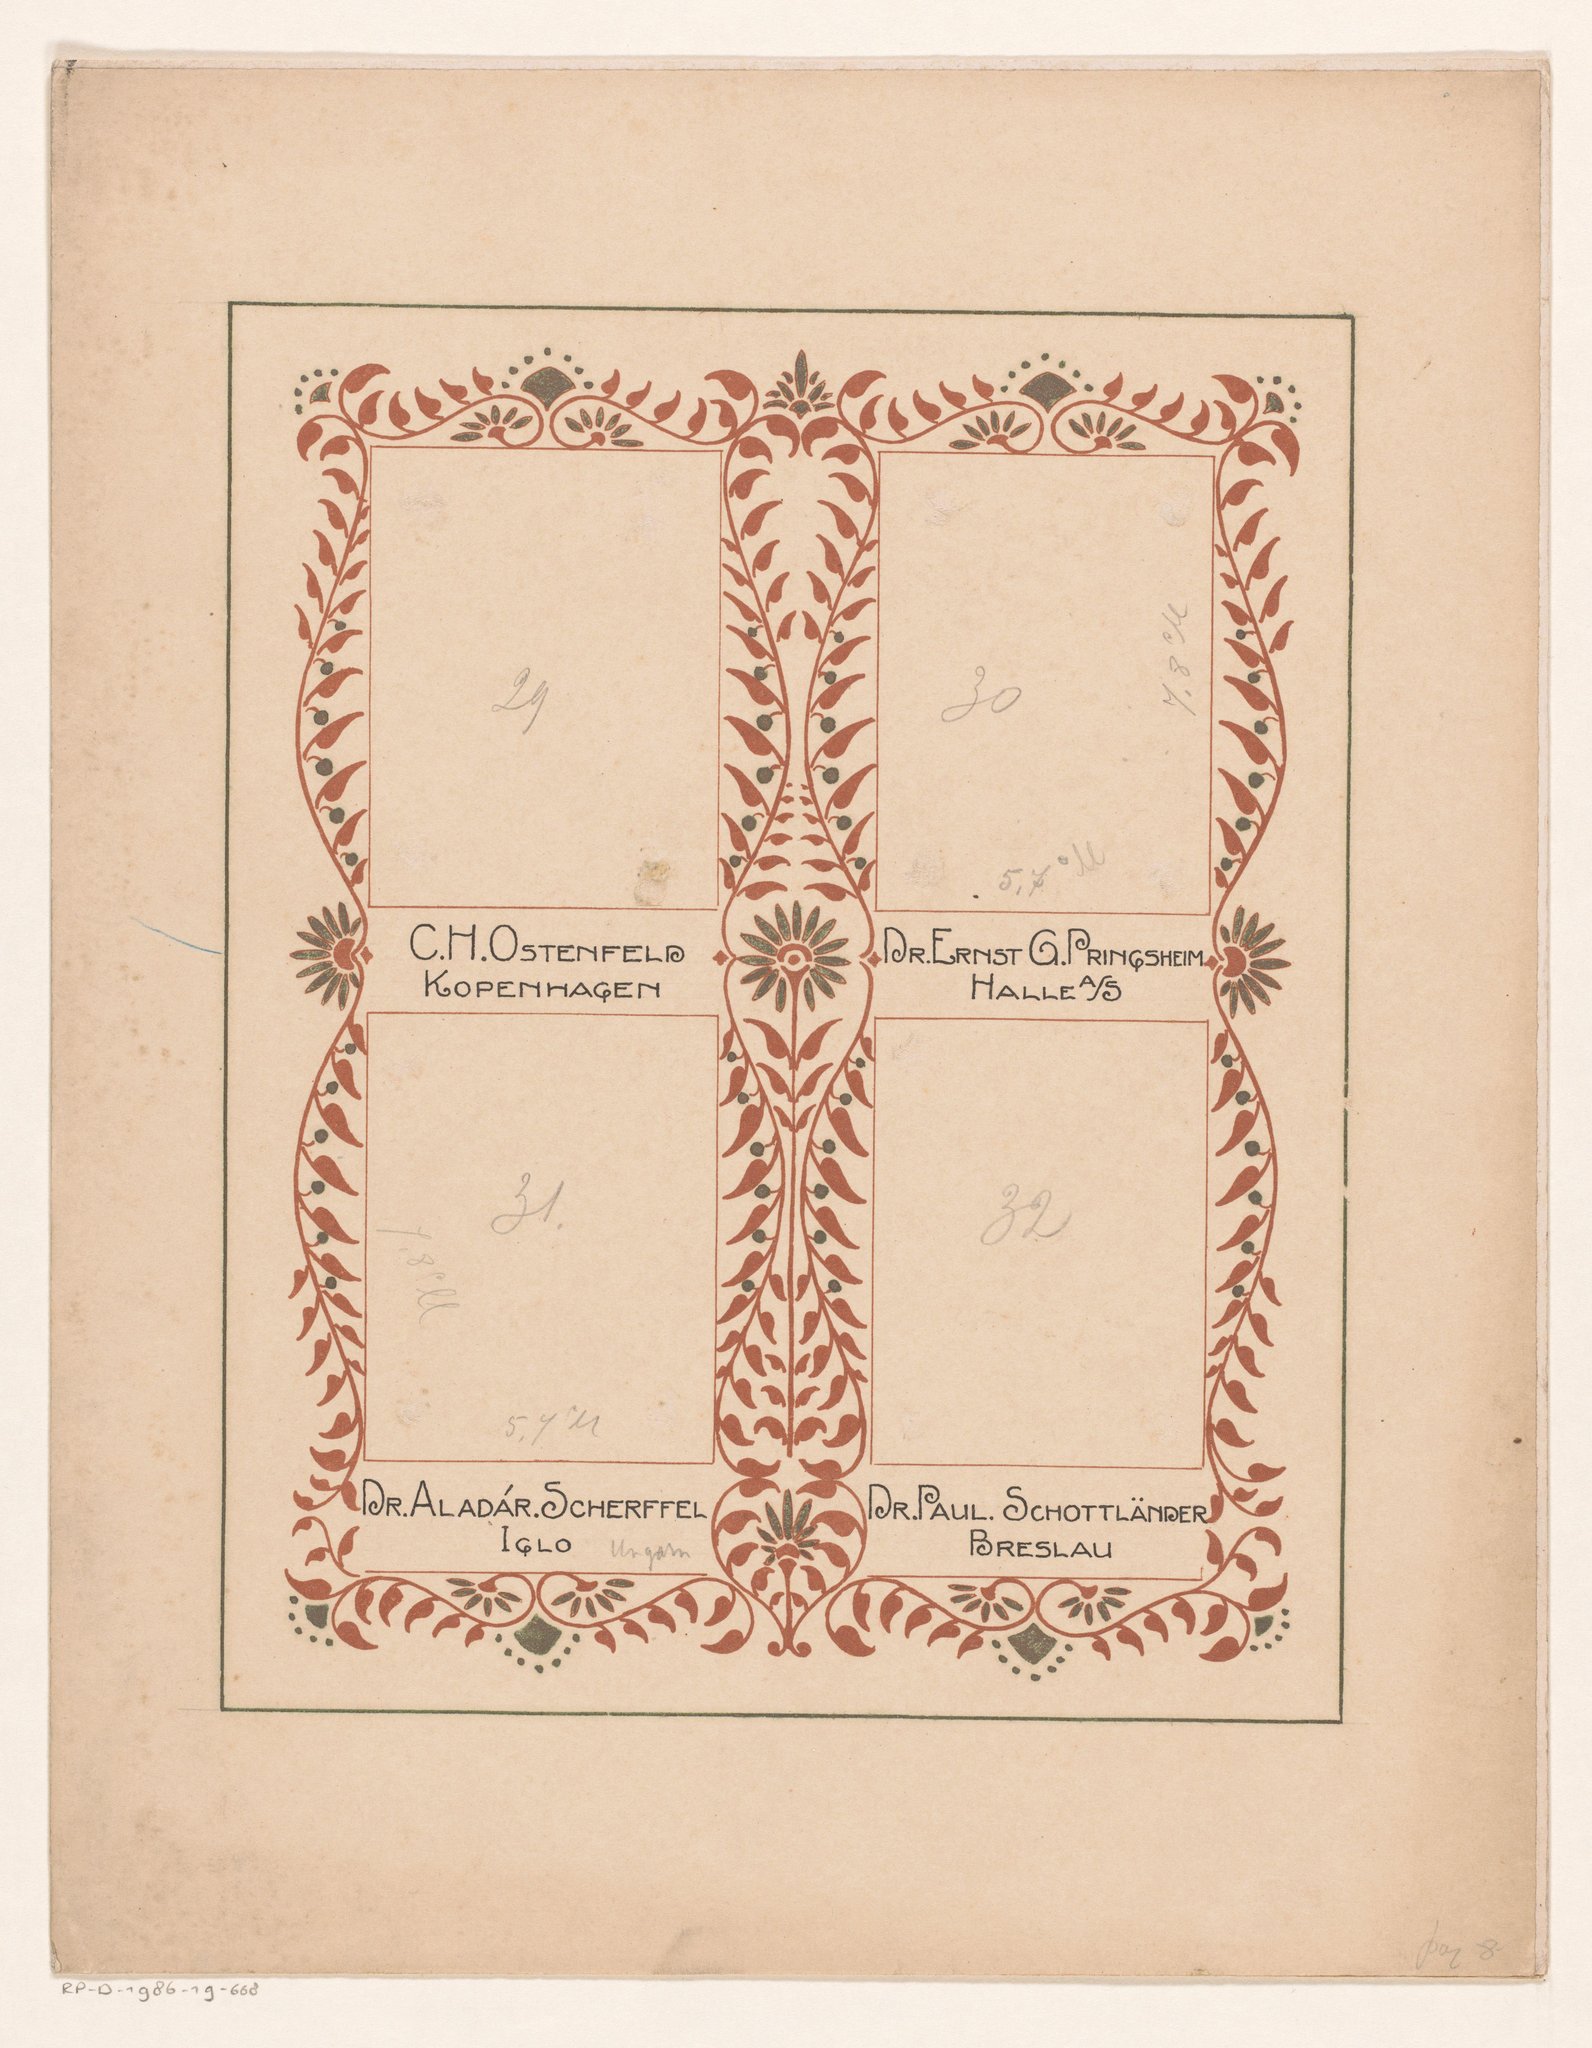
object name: drawing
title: Albumblad voor een album voor Prof. Hugo de Vries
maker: reinier willem petrus de vries (1874-1953)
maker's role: draughtsman, print maker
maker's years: 1874-1953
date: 1918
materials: paint, ink, paper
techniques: brush, lithograph, pen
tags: hugo de vries, flowers ~ ornament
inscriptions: collector's mark: ‘R:MVS.’, annotation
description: Rechthoekig kader met bloem- en bladornamenten met daarin vier vakken voor portretten met onder elk vak de naam van de geportretteerde.